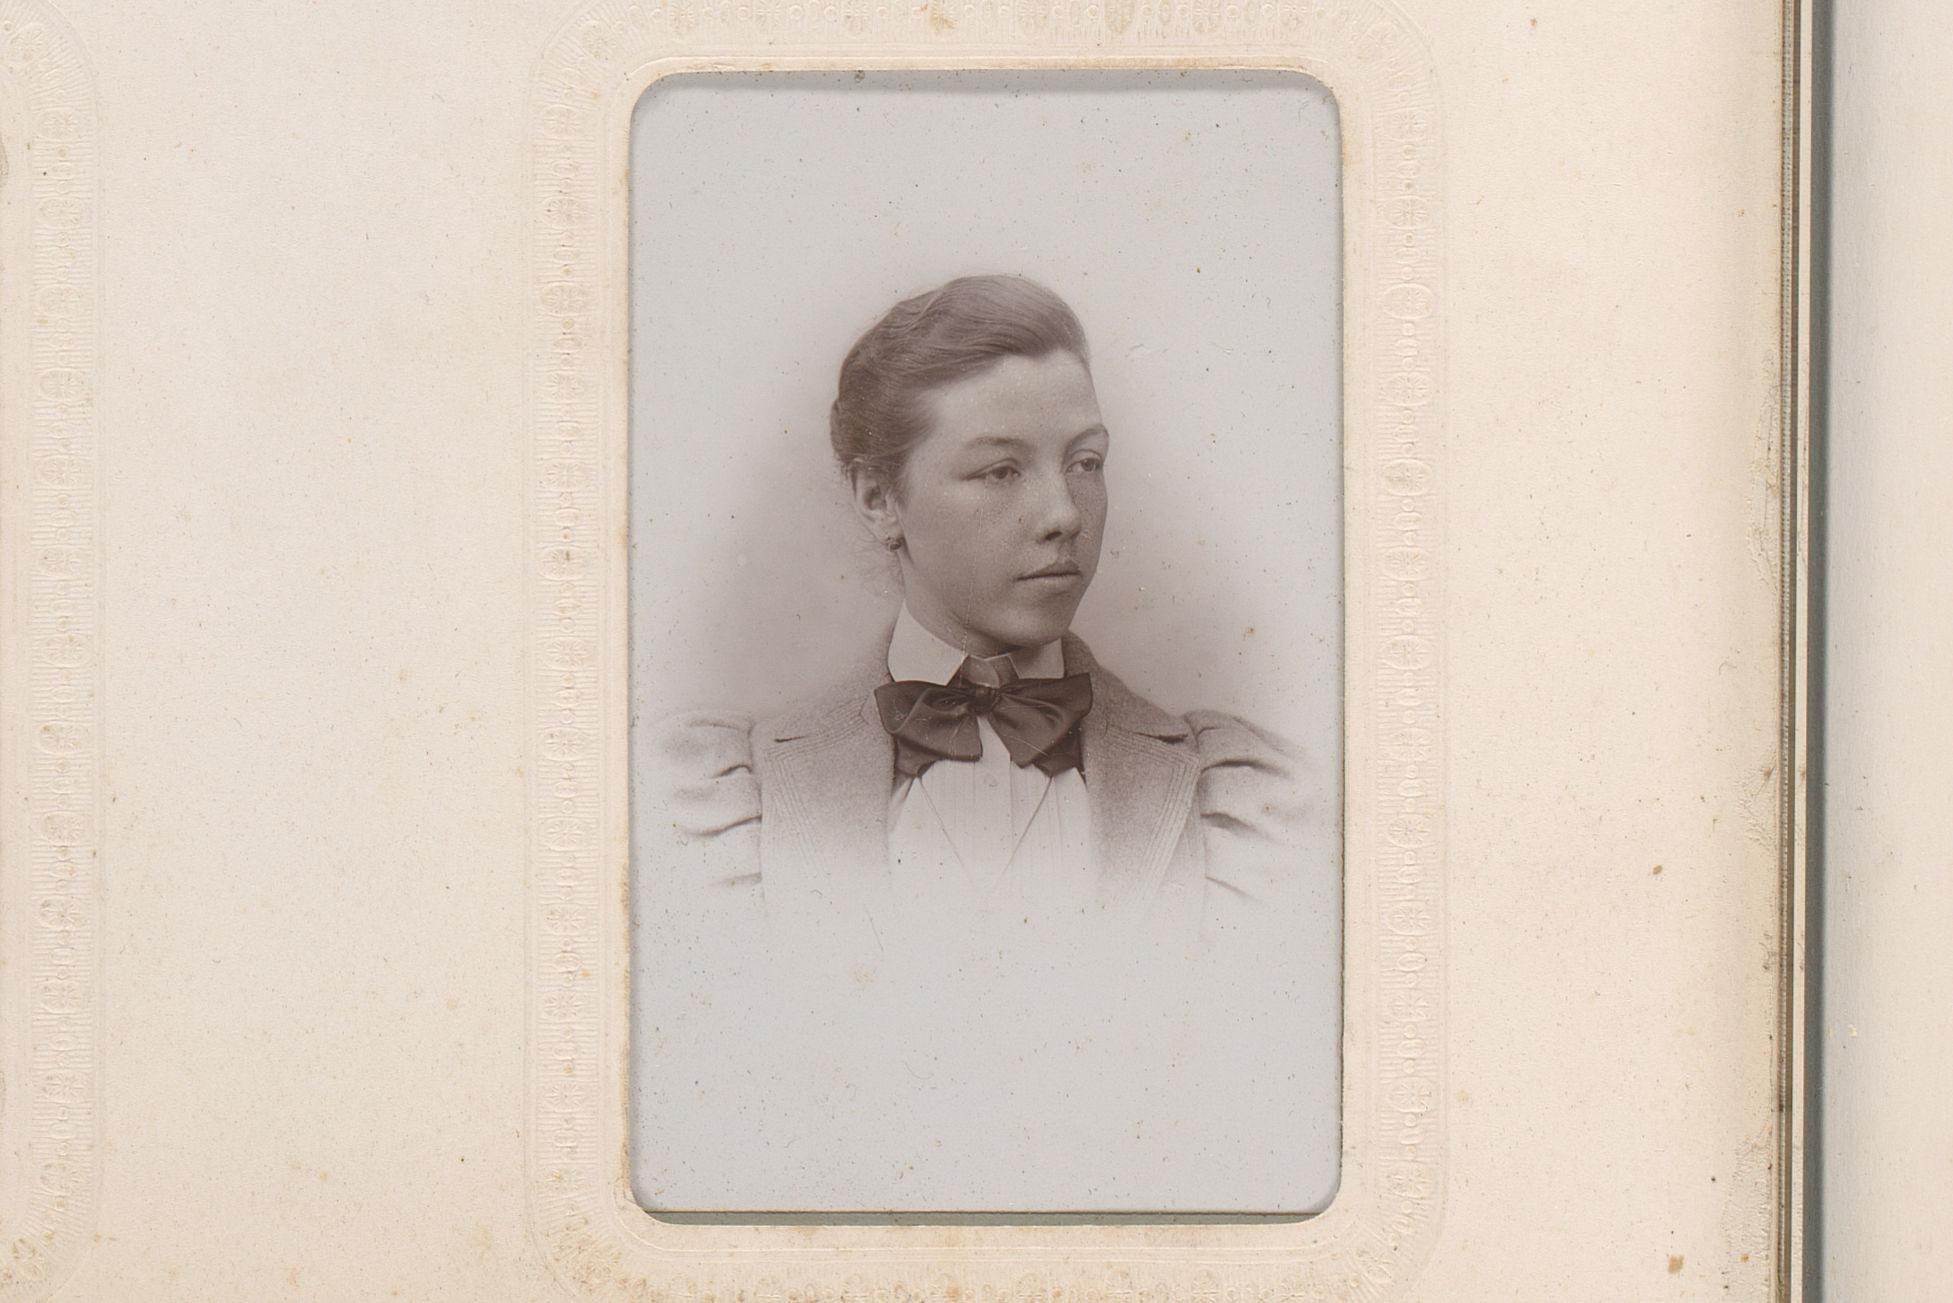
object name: album leaf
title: Portret van een meisje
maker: Anonymous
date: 1860-1900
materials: cardboard, photographic support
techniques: albumen print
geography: netherlands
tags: historical persons - bb - woman, girl (child between toddler and youth)